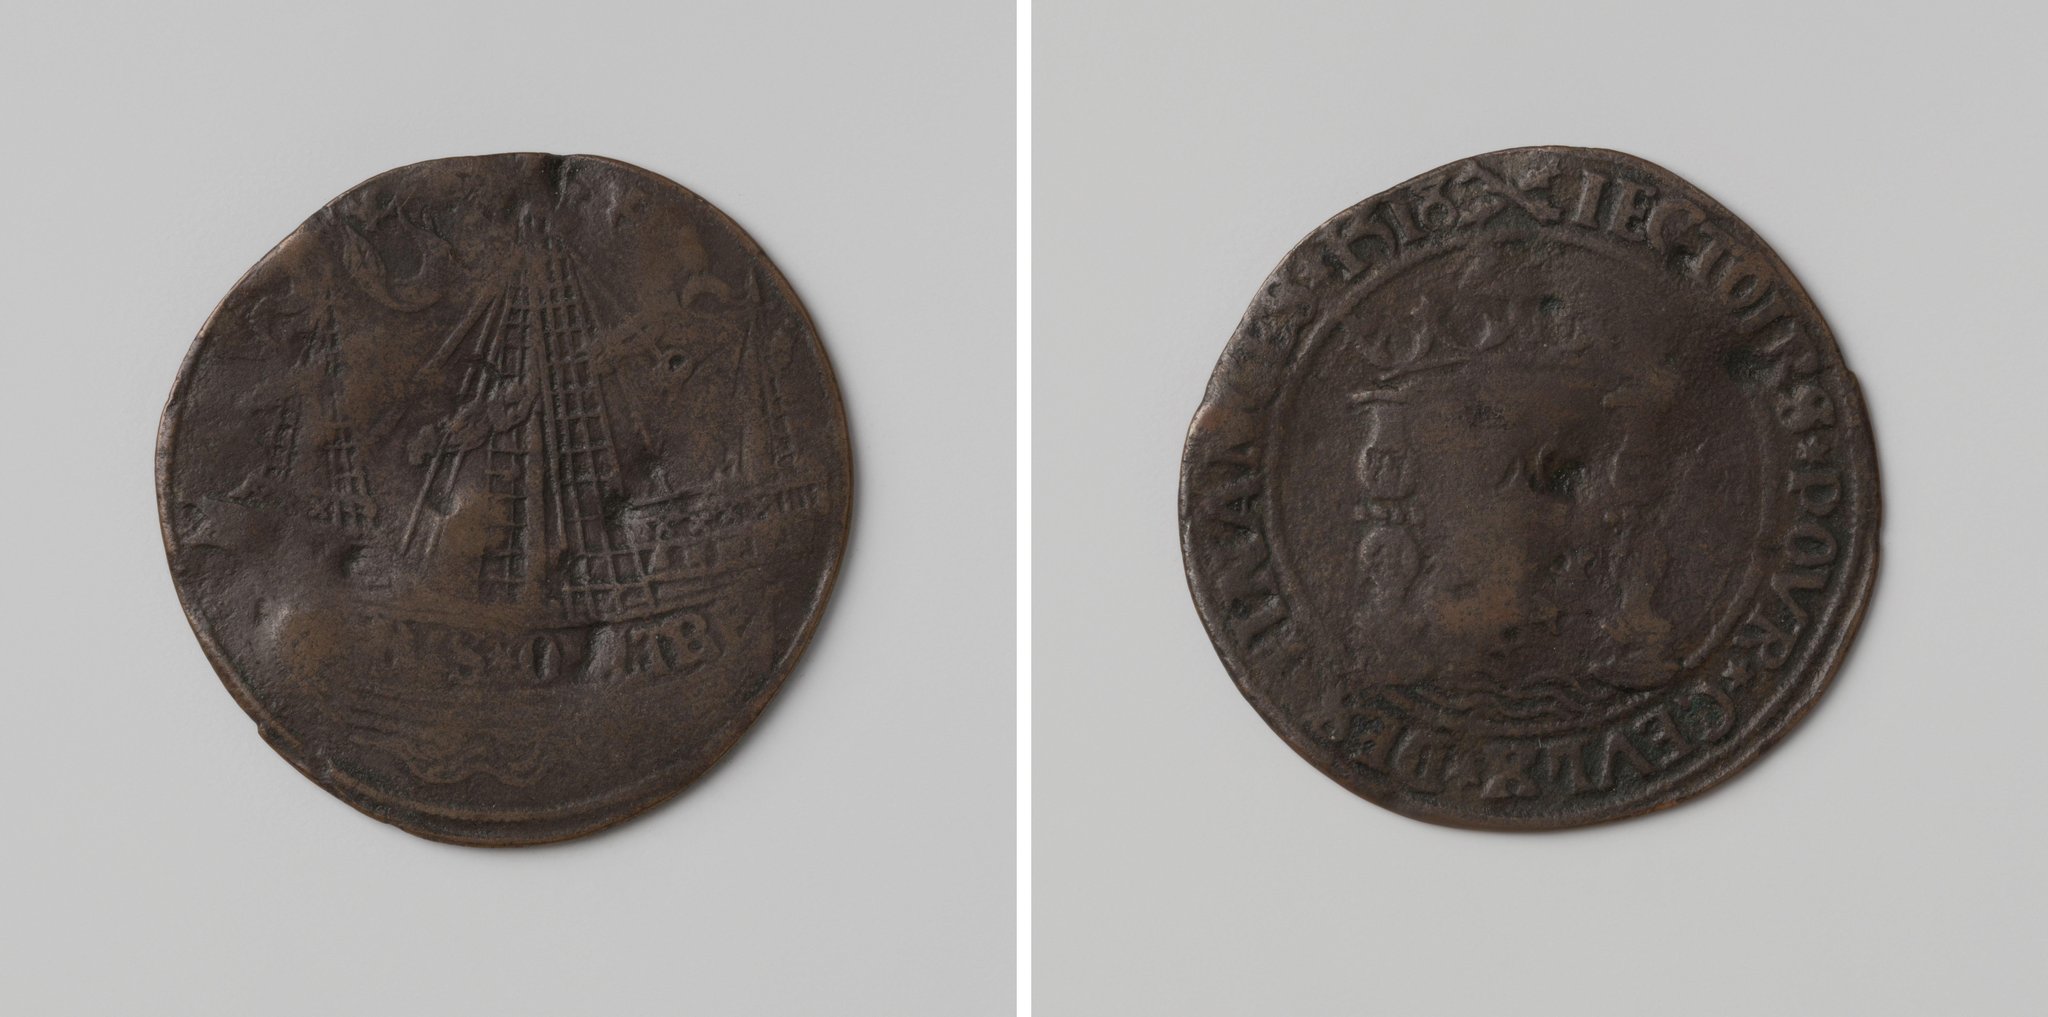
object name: jeton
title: Landing van Karel I bij Tazones in Spanje, rekenpenning van de raad van Financiën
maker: Anonymous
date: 1518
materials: copper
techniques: striking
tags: charles v (holy roman emperor and king of spain)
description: Koperen penning. Voorzijde: zeilende driemaster; op boord: opschrift. Keerzijde: vuurslag, steen en vonken tussen zuilen van Herkules onder kroon binnen omschrift